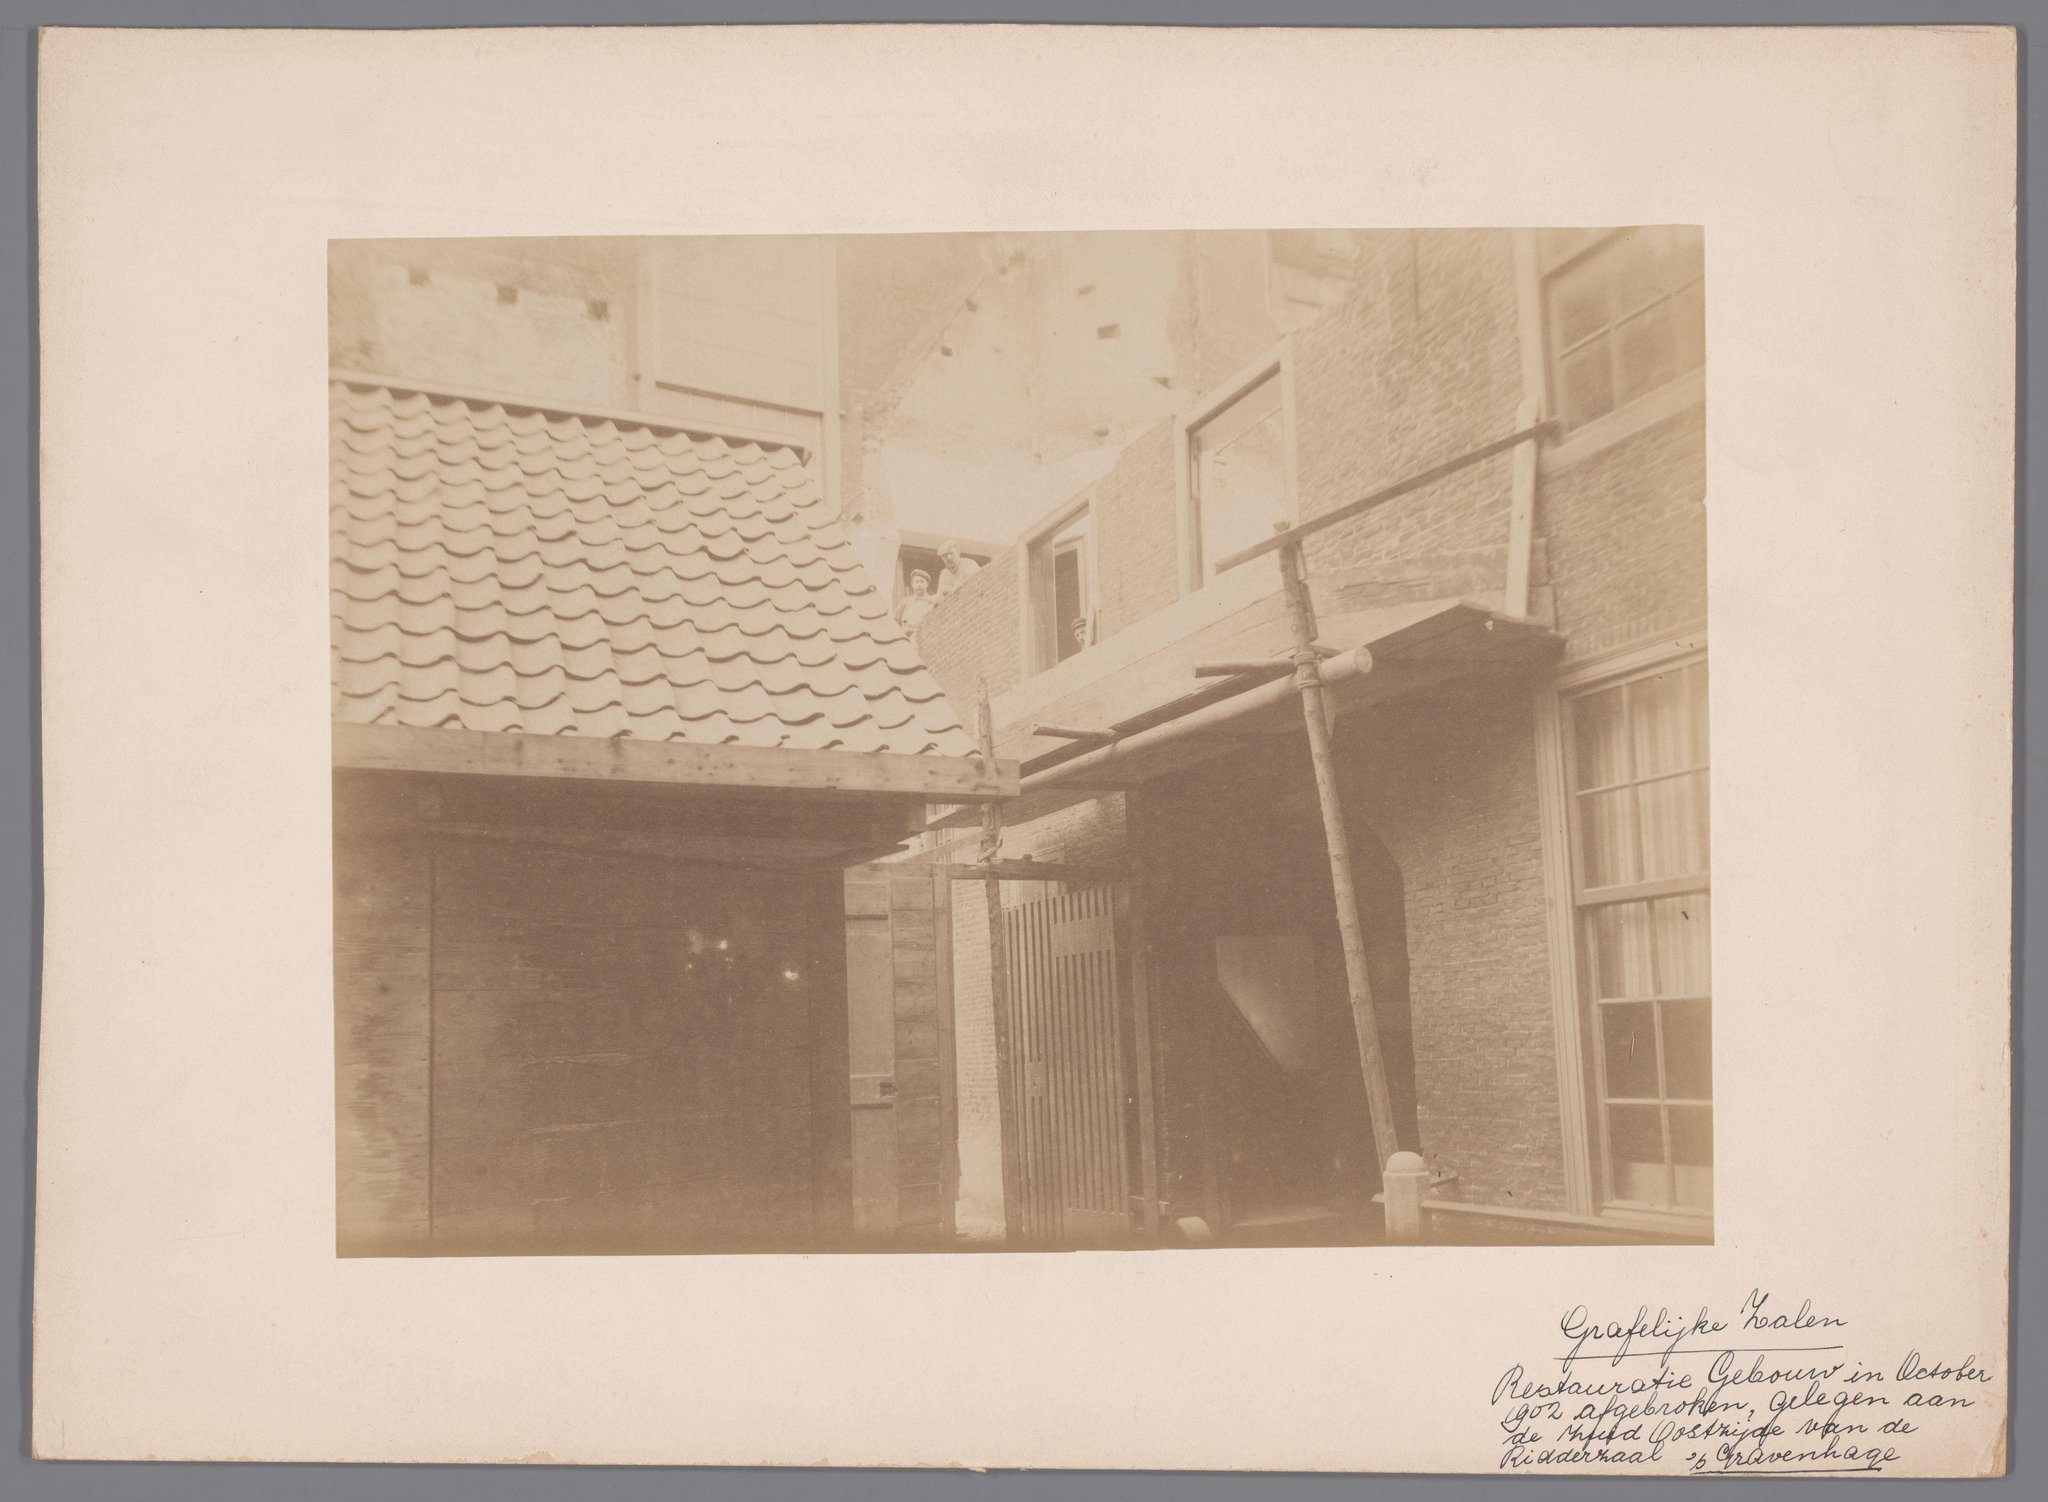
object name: photograph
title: Detail van de Grafelijke Zalen op het Binnenhof tijdens de restauratie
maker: anoniem (monumentenzorg)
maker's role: fotograaf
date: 1901-1902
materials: cardboard, photographic support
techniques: albumen print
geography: binnenhof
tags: national government, courtyard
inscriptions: annotation: ‘'s Gravenhage - Binnenhof (Z.H.)/ gebouw in oct 1902 afgebroken/ gelegen aan de Zuid-oostzijde v/d Ridderzaal’, annotation: ‘Grafelijke Zalen/ Restauratie gebouw in October 1902 afgebroken, gelegen aan de zuid Oostzijde van de Ridderzaal 's Gravenhage’